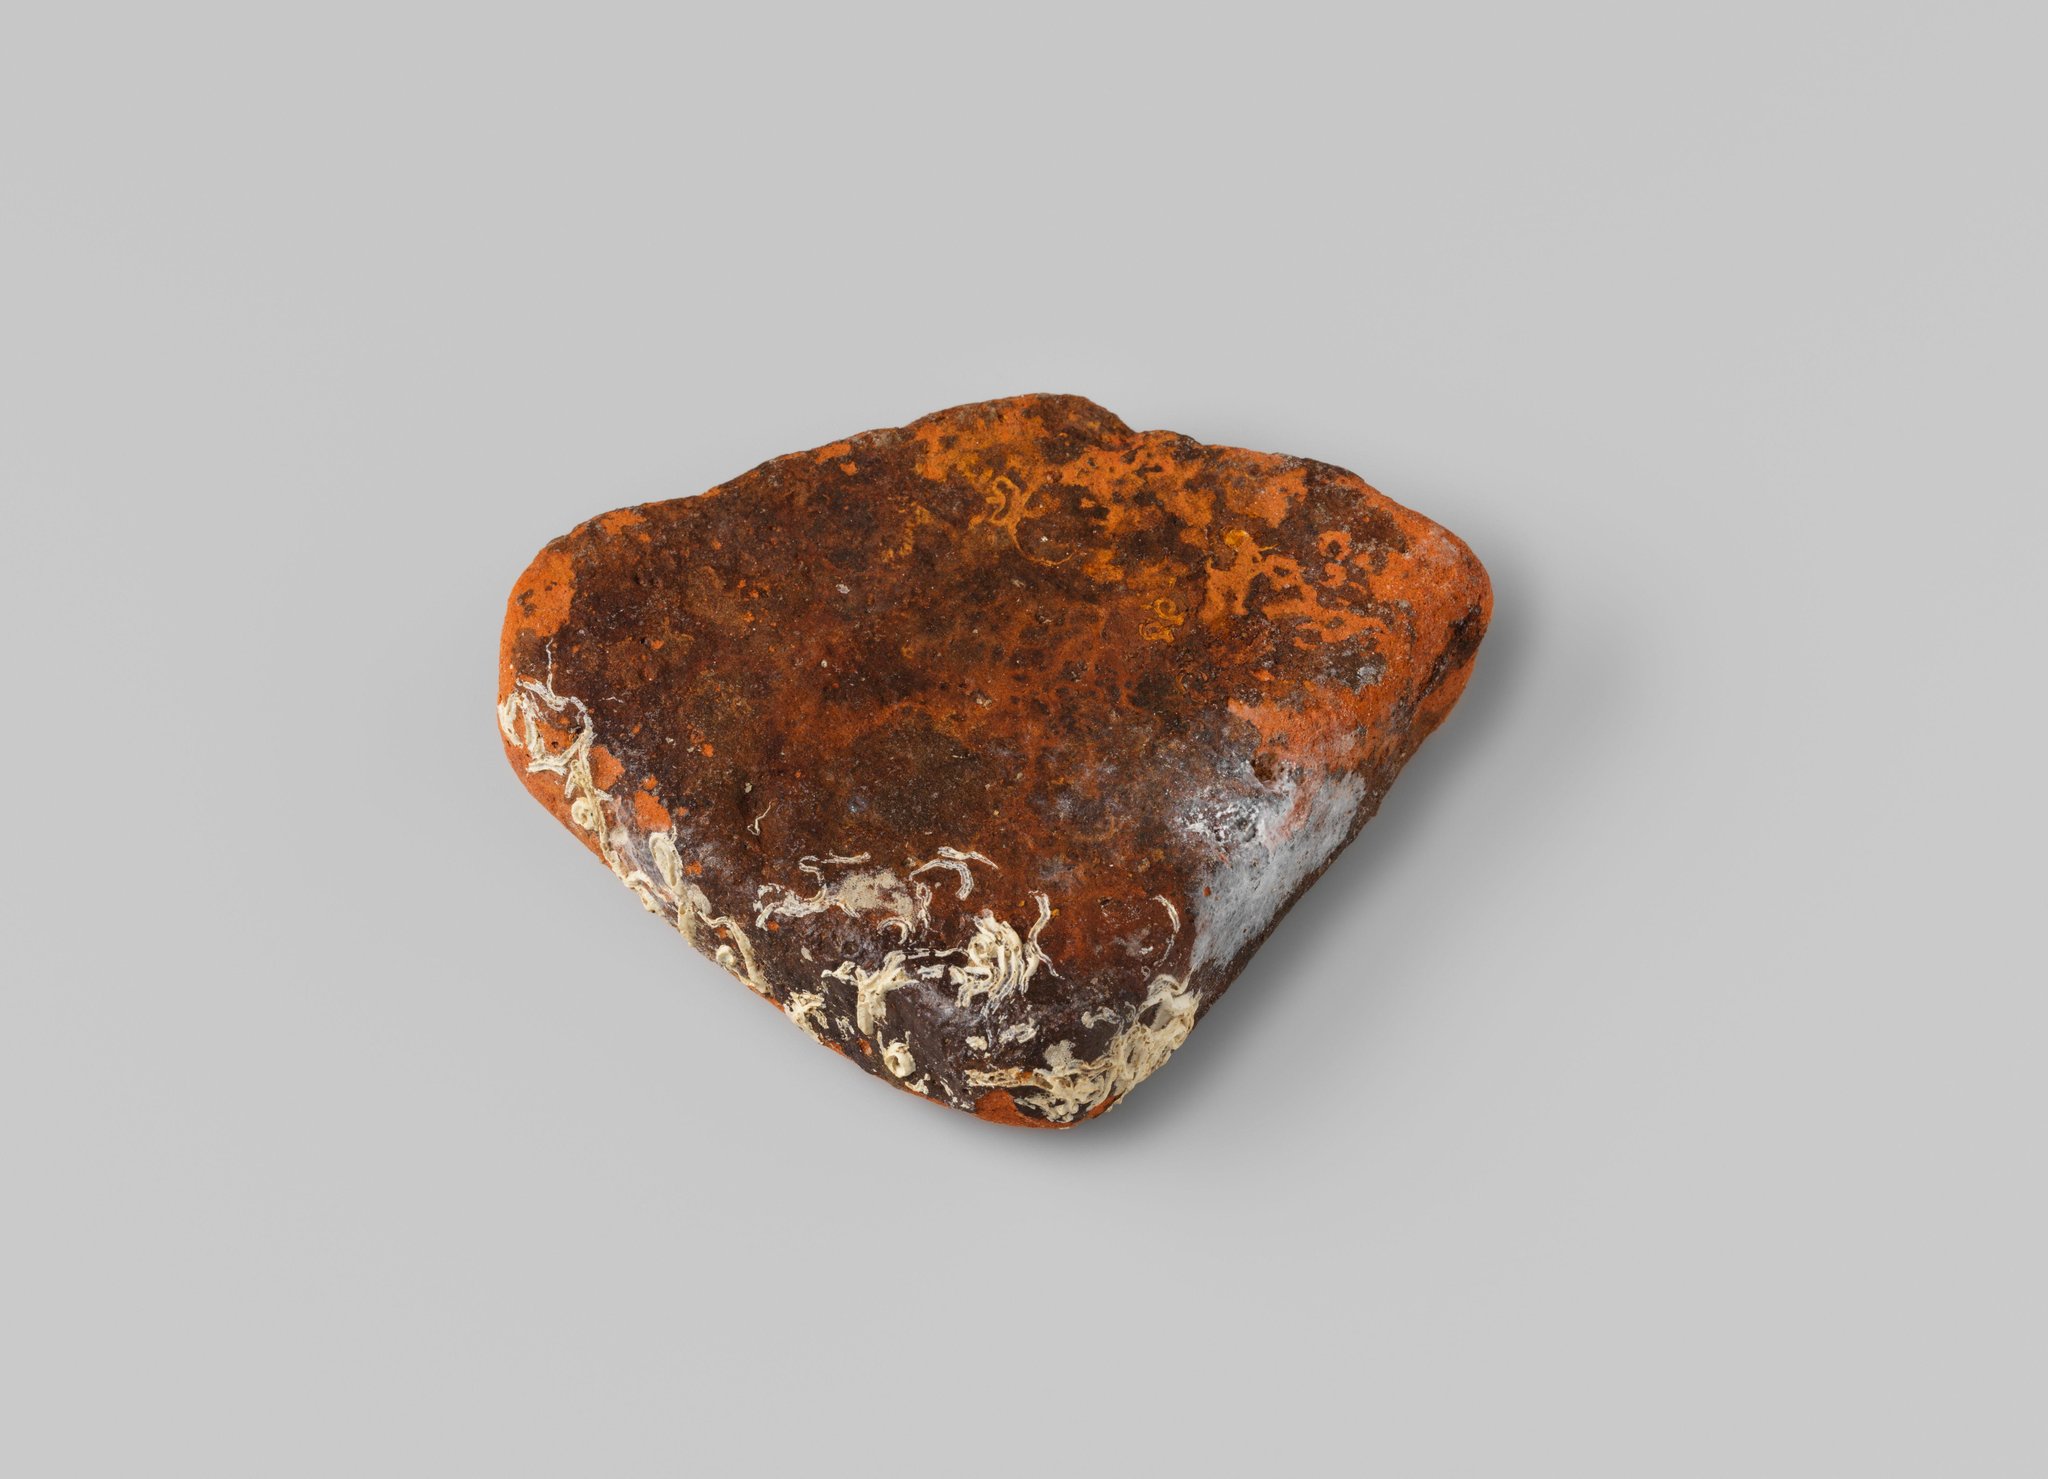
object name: brick clay product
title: Fragment baksteen uit het wrak van de Oostindiëvaarder Hollandia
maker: Anonymous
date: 1700-1743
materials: brick